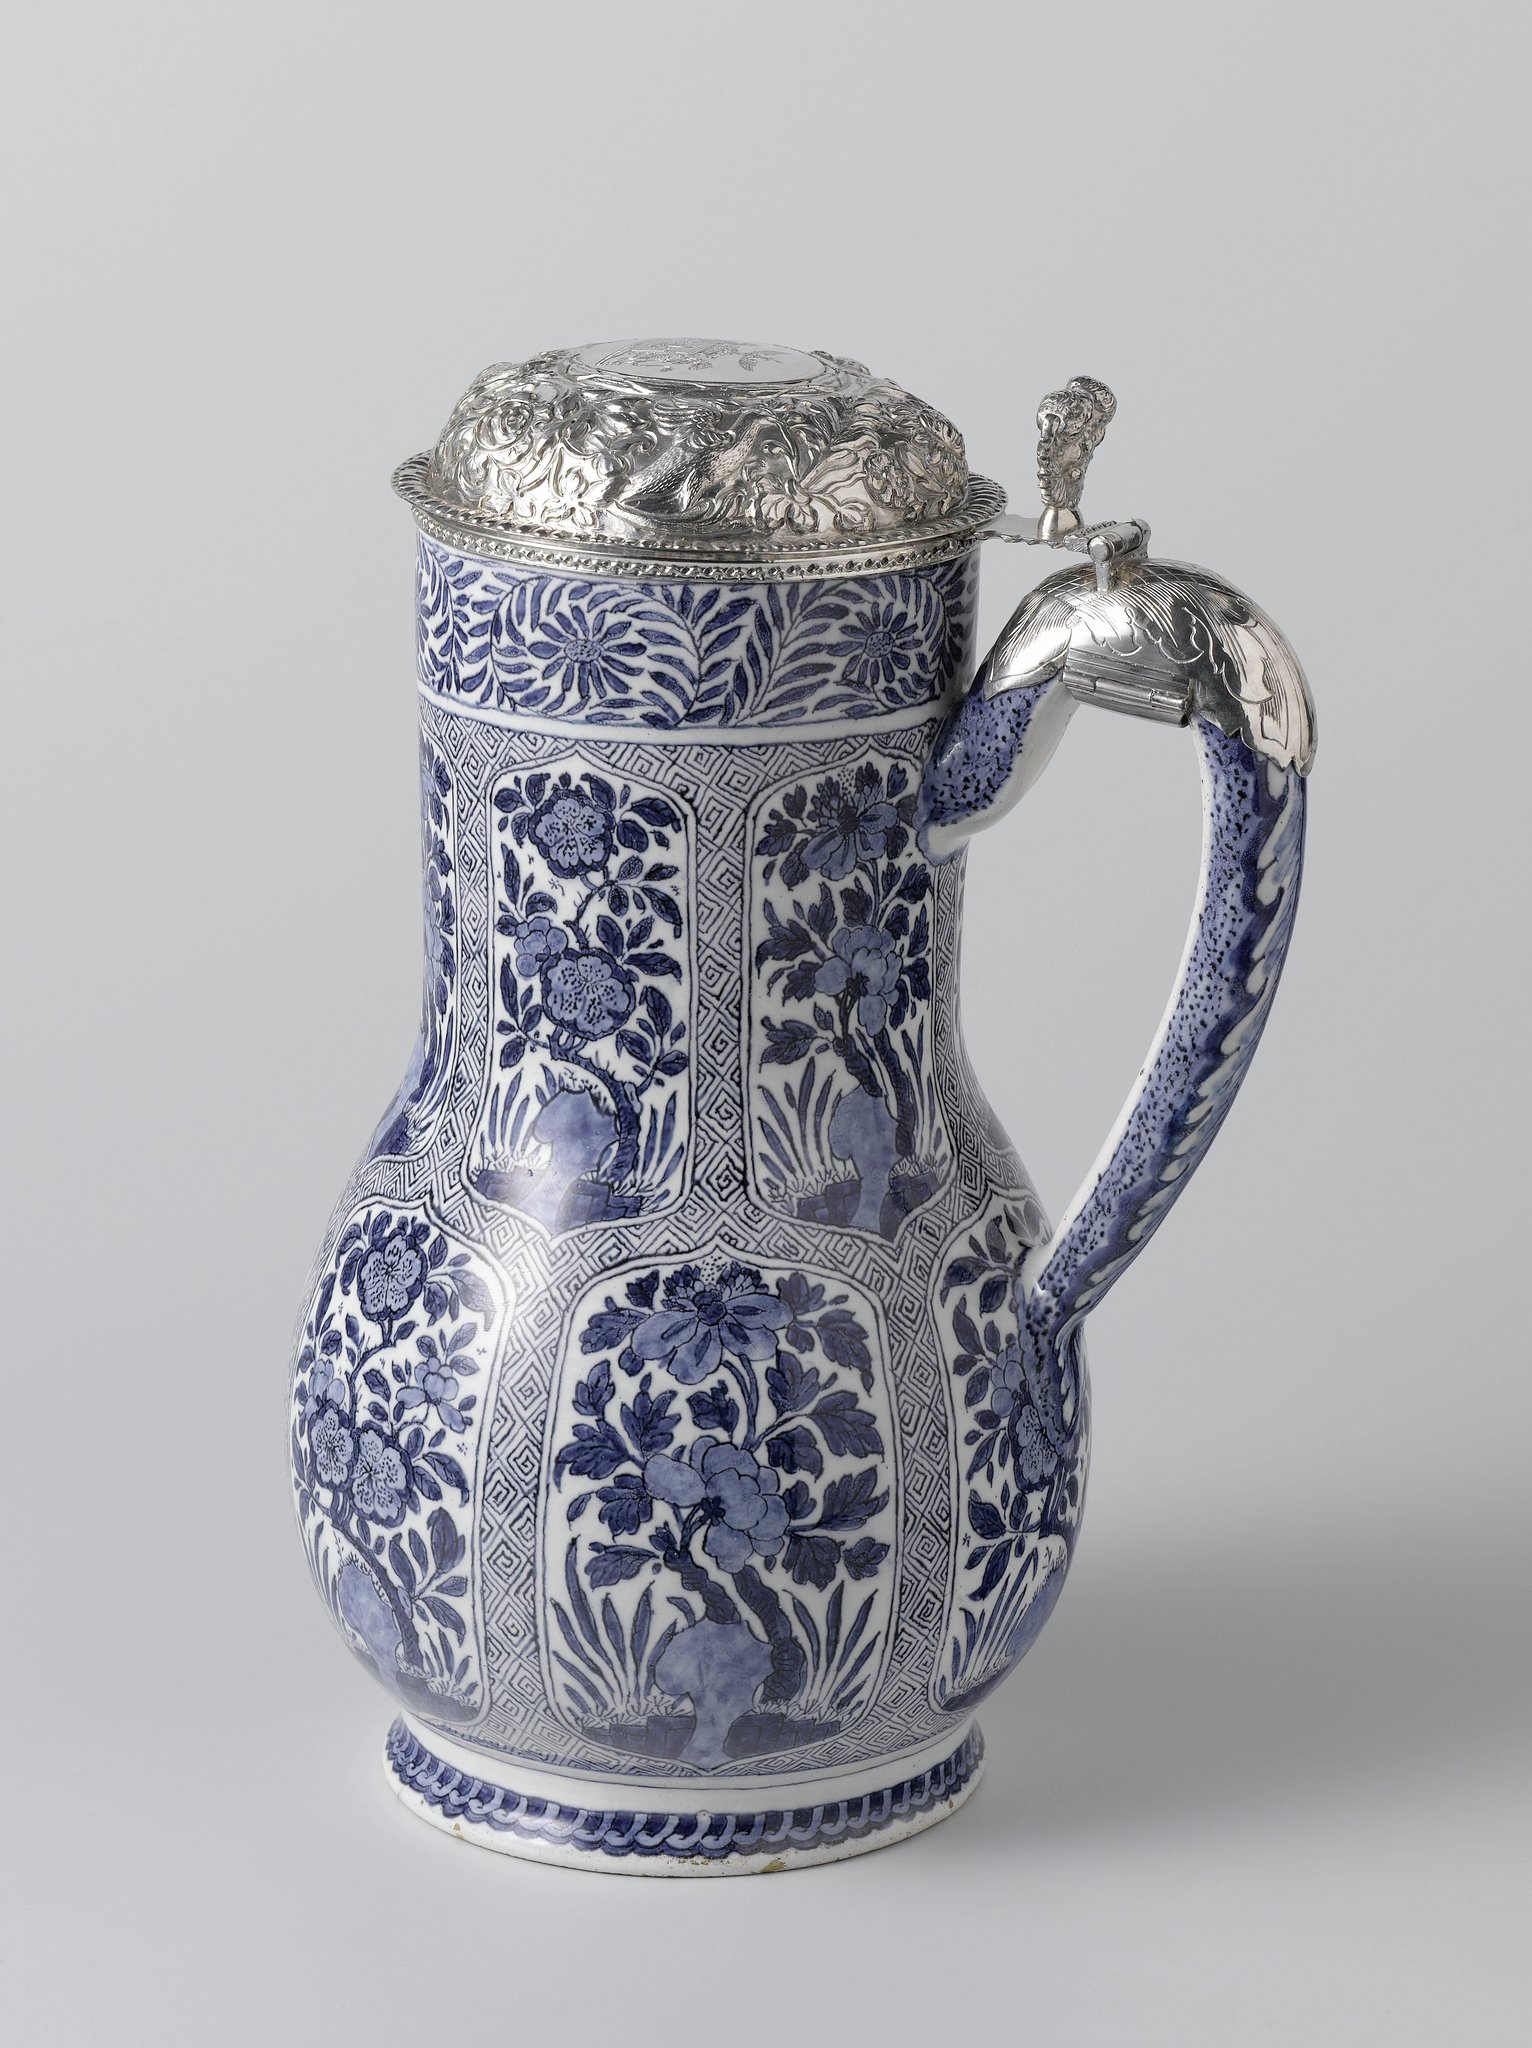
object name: ewer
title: Lidded jug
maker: Anonymous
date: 1700-1730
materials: earthenware, silver, glaze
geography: delft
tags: flowers ~ ornament